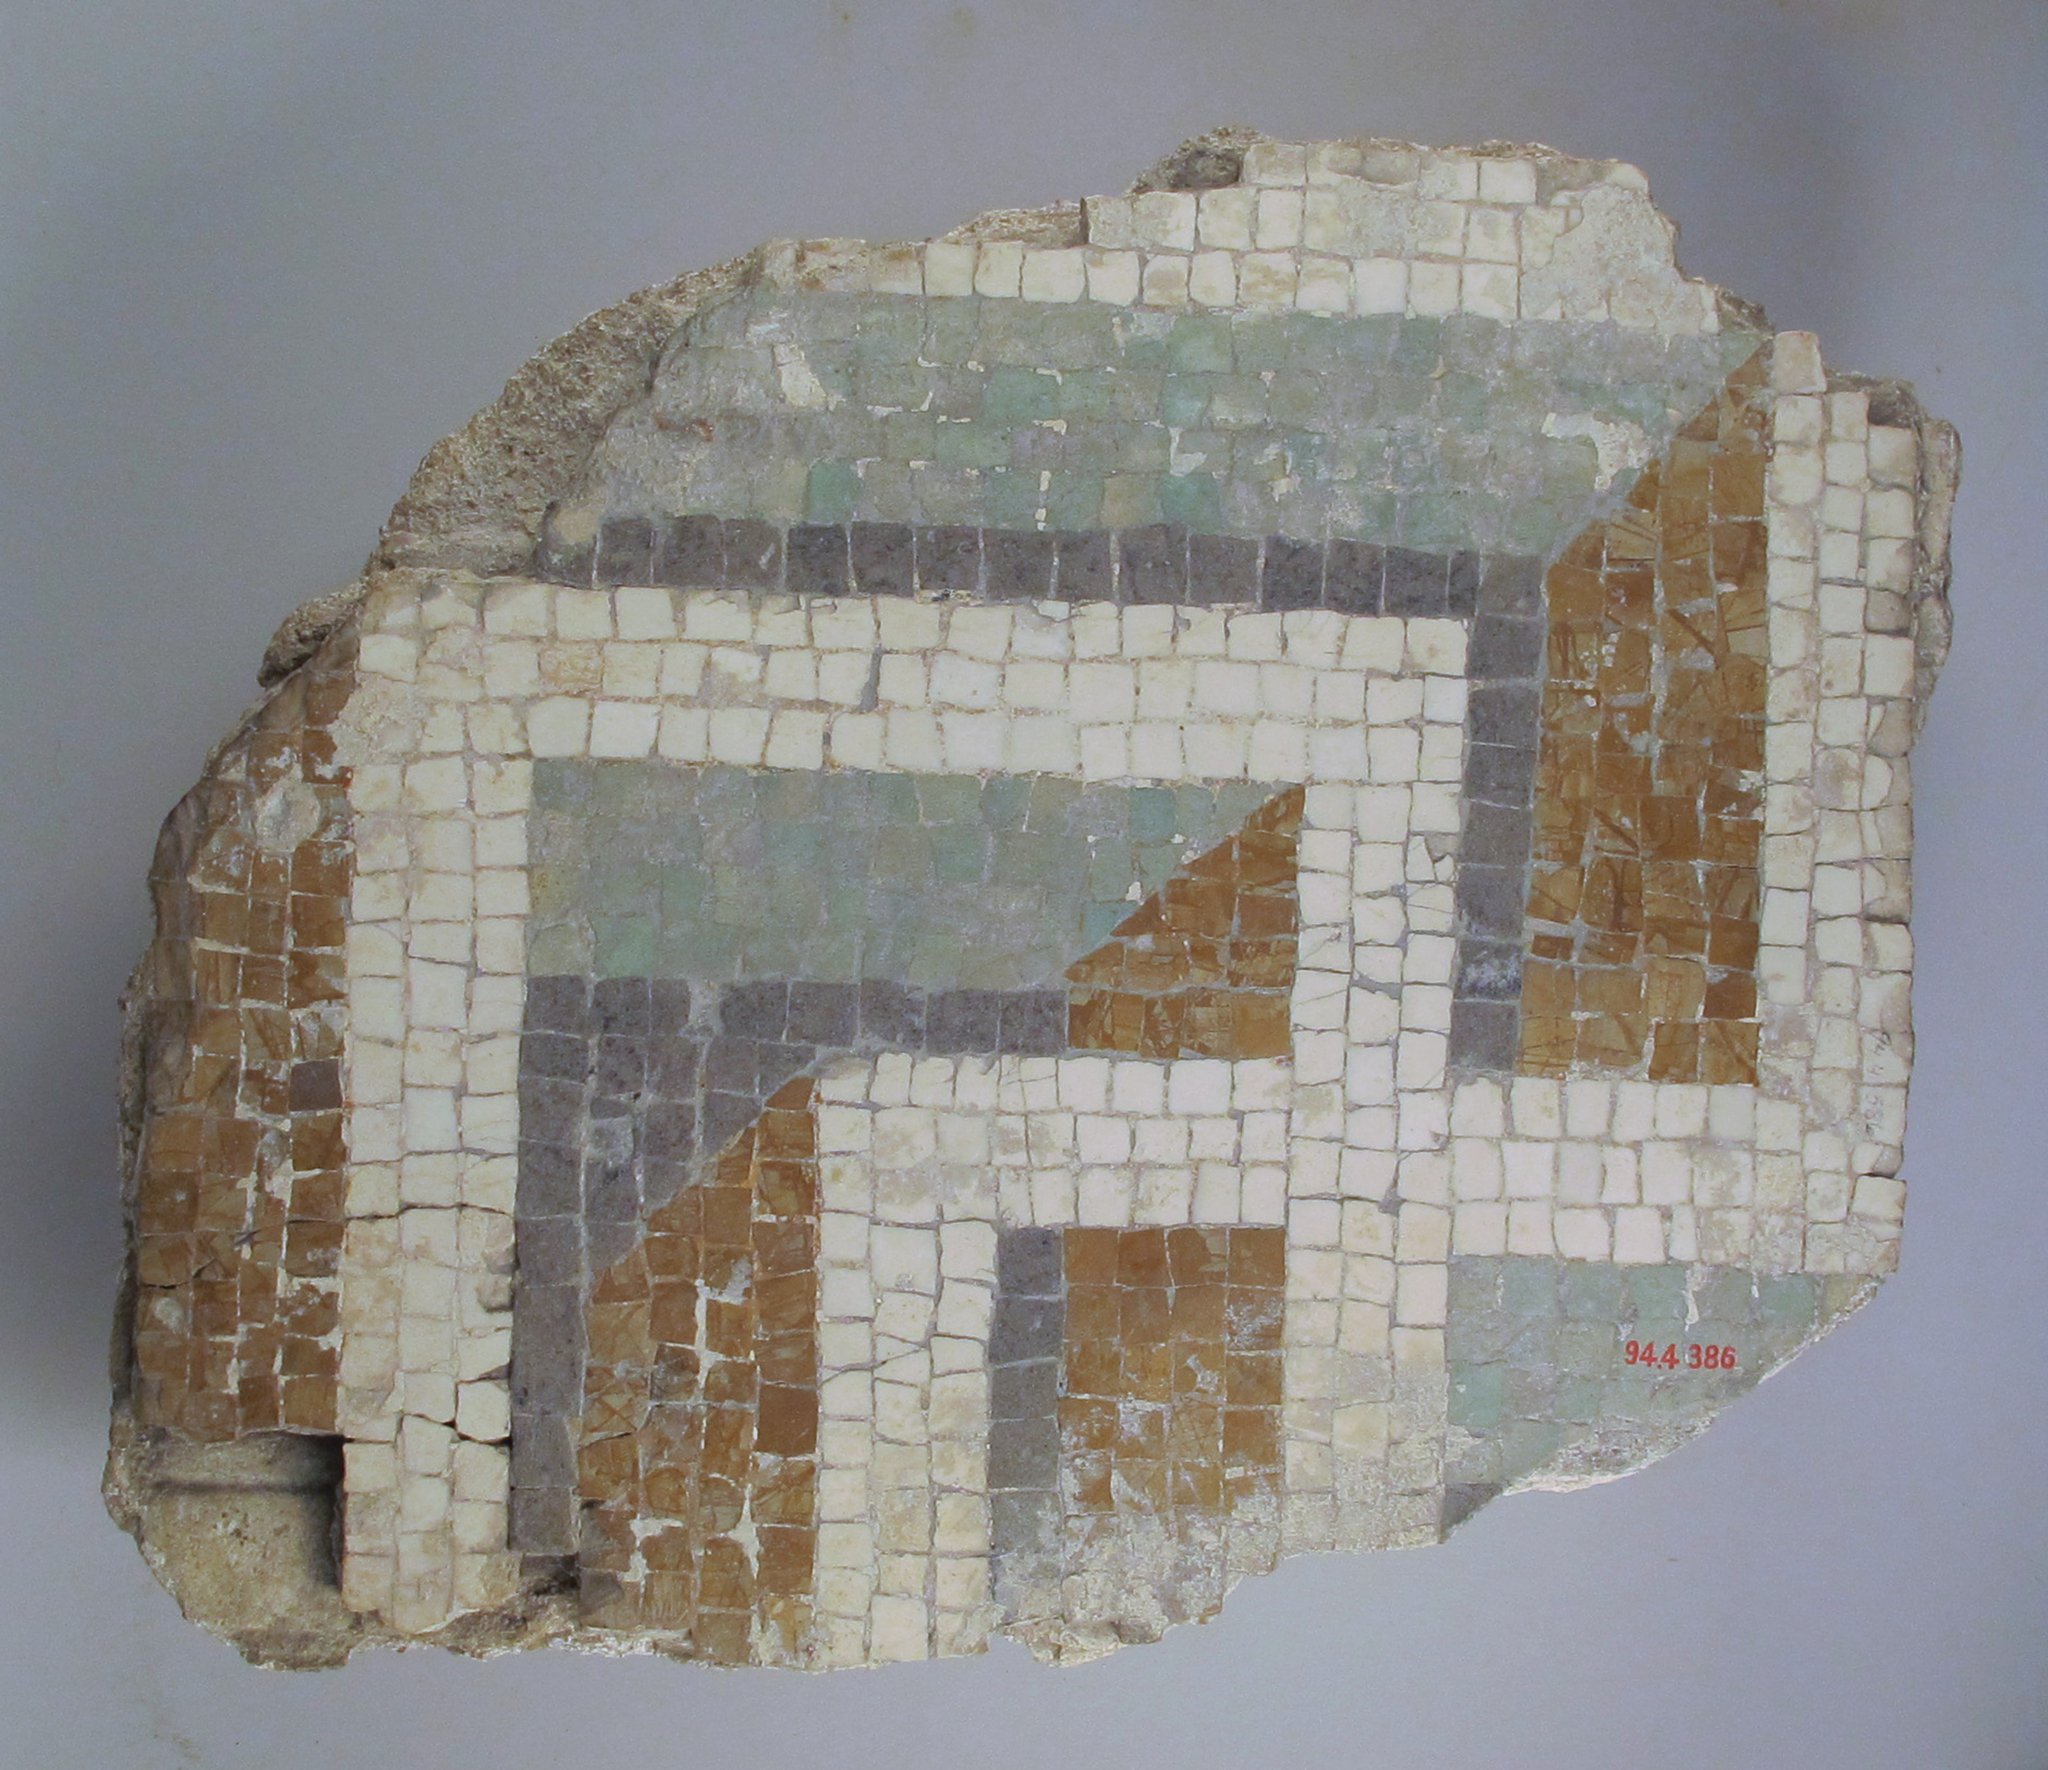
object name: mosaic floor fragment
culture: roman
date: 670 BCE-330 CE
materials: mortar